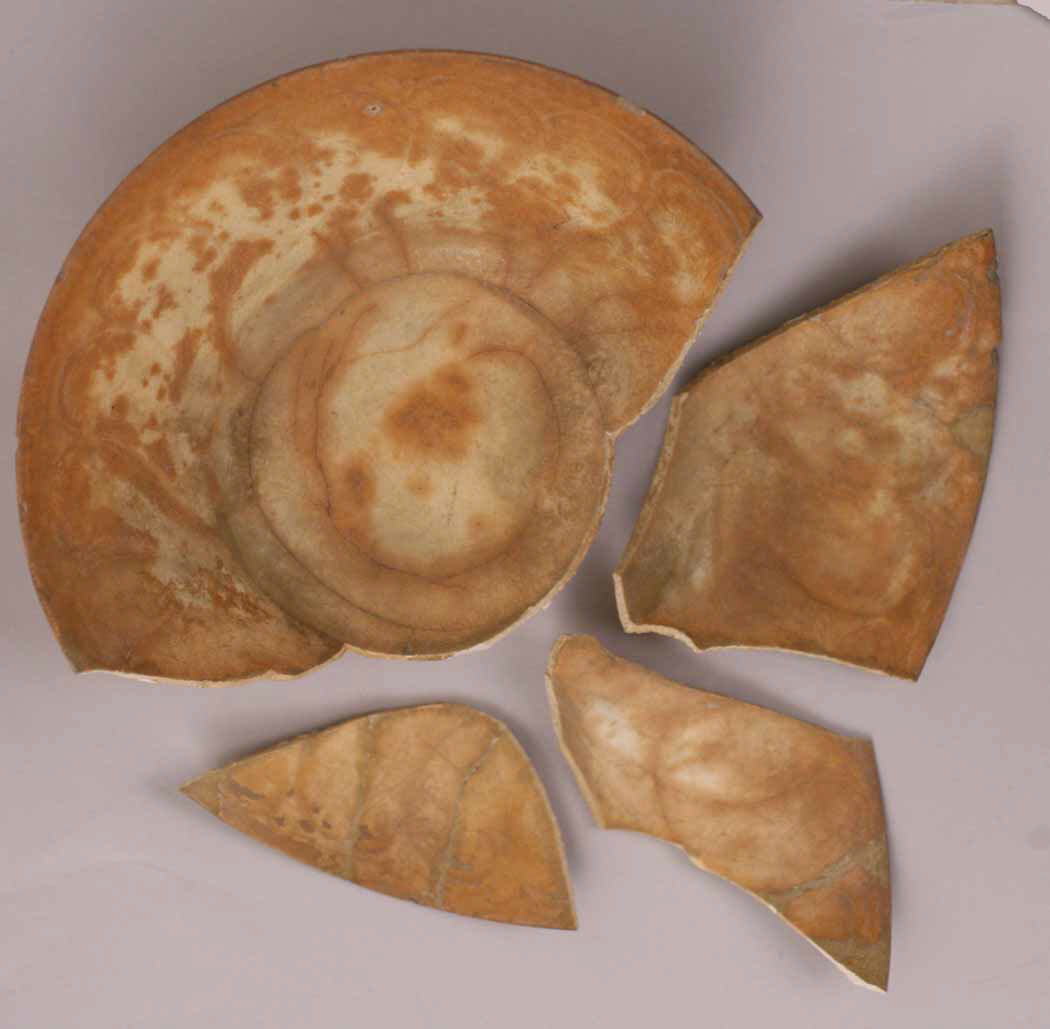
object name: bowl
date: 701-900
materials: earthenware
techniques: glazing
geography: iran